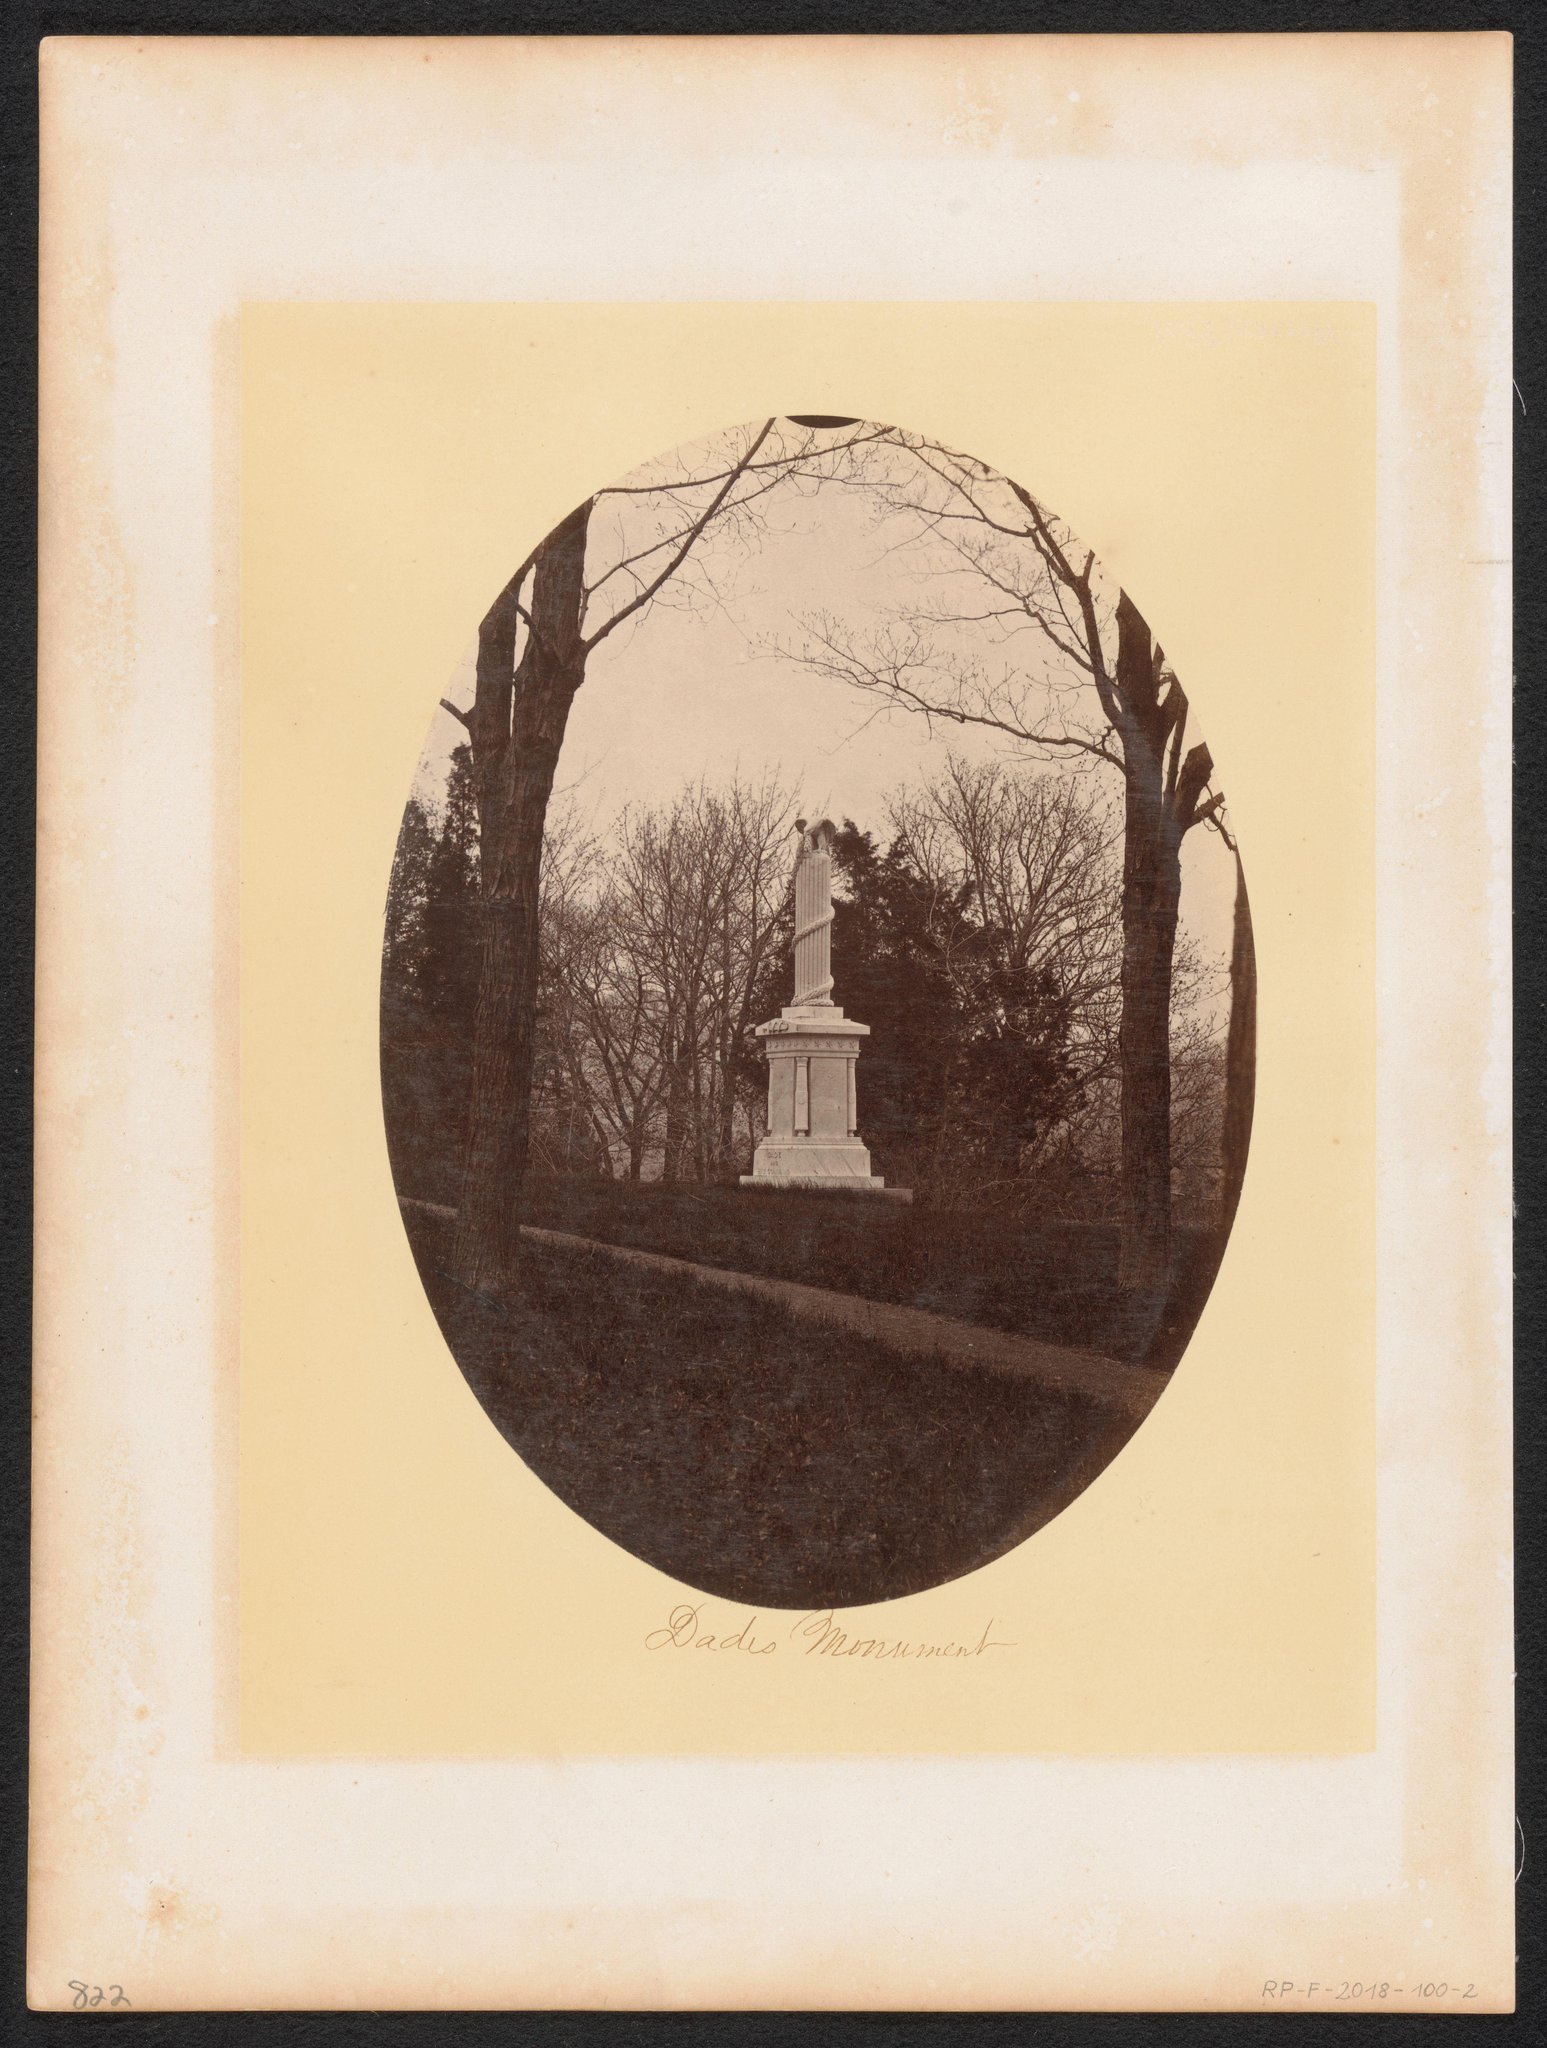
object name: photograph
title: Dades Monument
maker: george kendall warren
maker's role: fotograaf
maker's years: 1833-1884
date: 1867-1868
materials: cardboard, paper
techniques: albumen print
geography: west point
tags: grave, tomb, monument, statue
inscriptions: inscription: ‘Dades Monument’